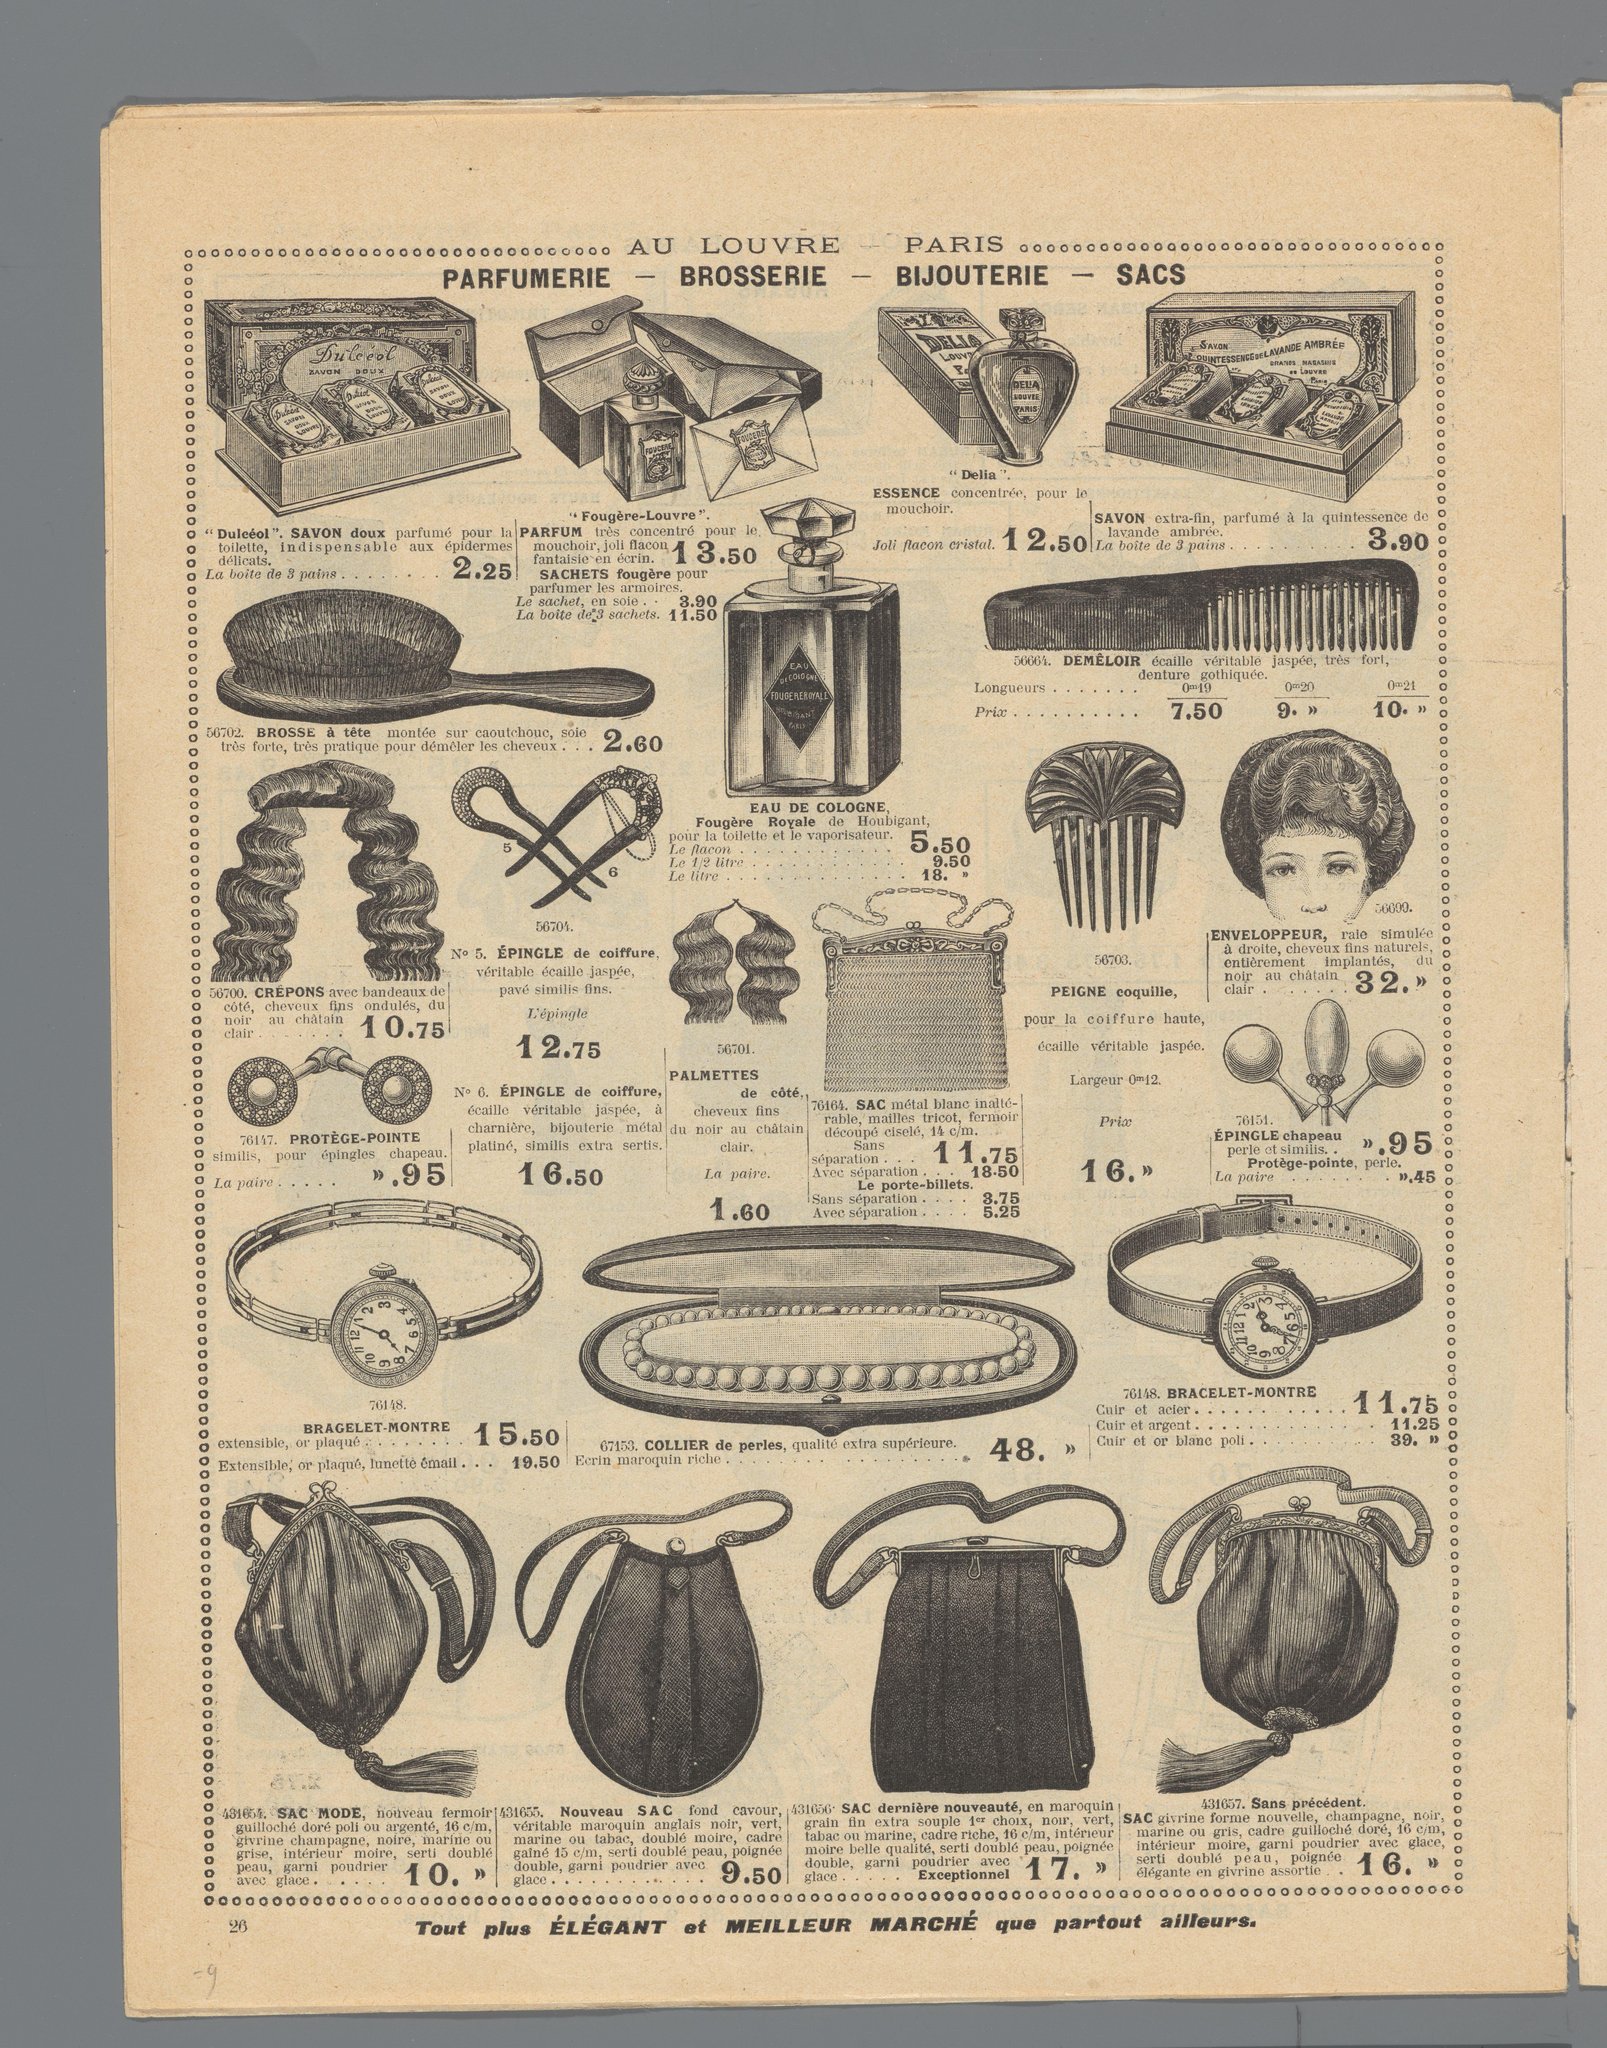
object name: print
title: Au Louvre, Paris: Lundi 2 Mars: Nouveautés d'été: pagina 26: pagina met advertenties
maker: Anonymous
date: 1913-1915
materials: paper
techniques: photography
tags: fashion plates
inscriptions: title: ‘Au Louvre, Paris: Lundi 2 Mars: Nouveautés d'été’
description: Pagina in "Au Louvre - Paris" : pagina 26: advertenties van haarborstels, kammen, (haar)sieraden, horloges en tasjes.